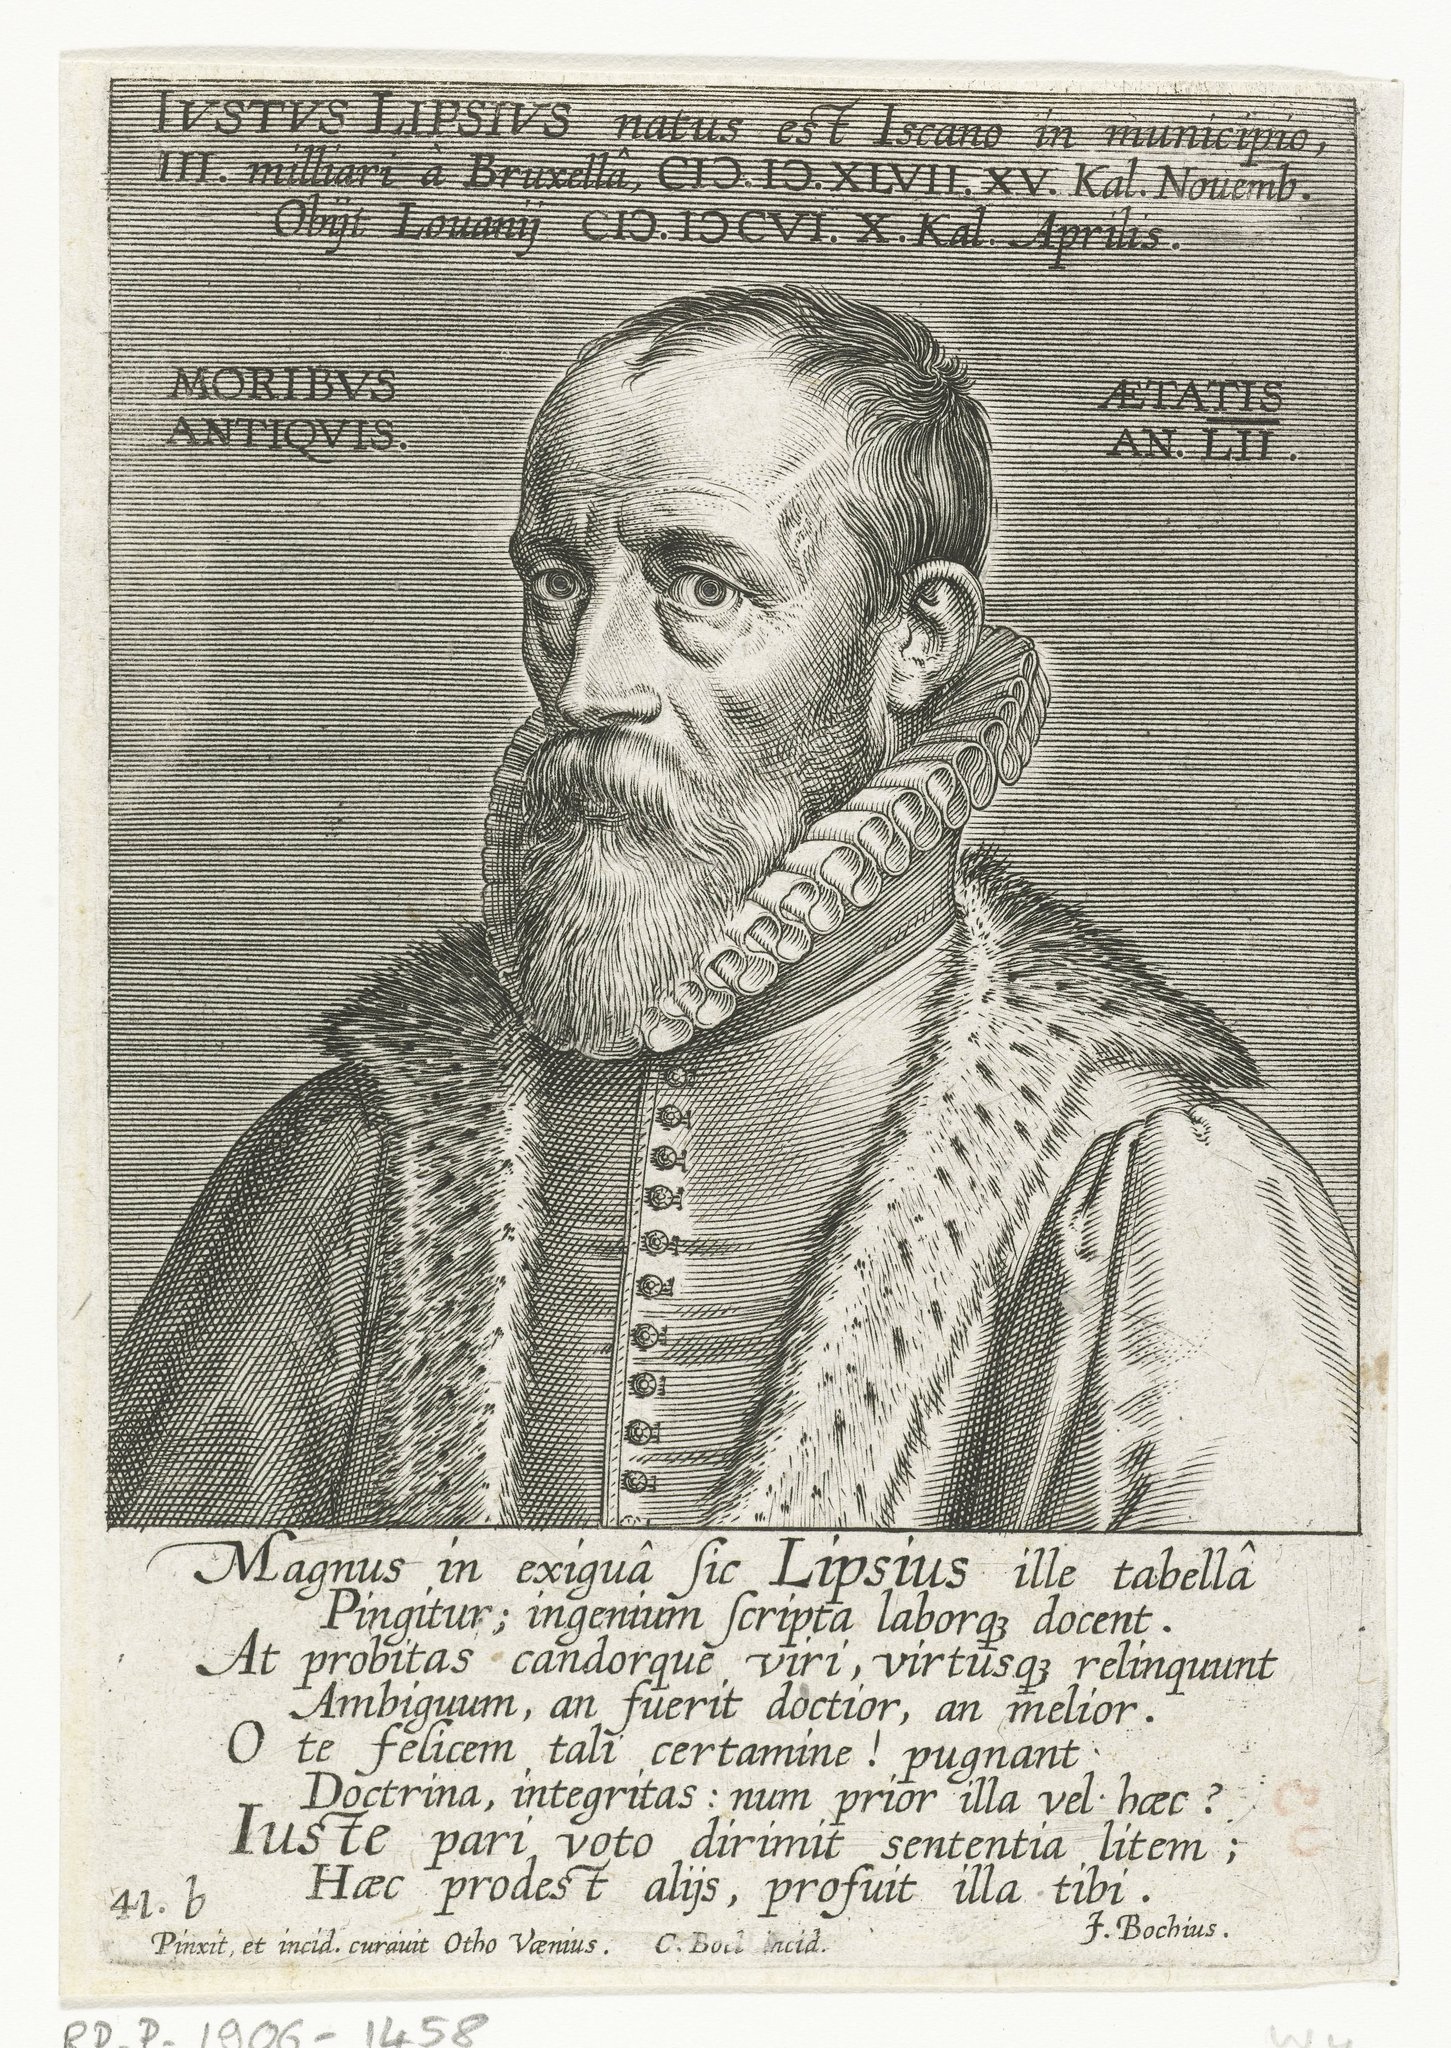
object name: print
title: Portret van Justus Lipsius op 52-jarige leeftijd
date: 1606-1629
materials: paper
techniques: engraving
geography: southern netherlands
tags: louvain, justus lipsius, aspects of science in general (+ portrait of scholar, scientist)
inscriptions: collector's mark: Lugt 2228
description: Borstbeeld van de humanist Justus Lipsius. Met opschriften in het Latijn. Links zijn lijfspreuk "Moribus antiquis", naar oude gewoonten. Onder het portret een vers op zijn leven door Joannes Bochius.